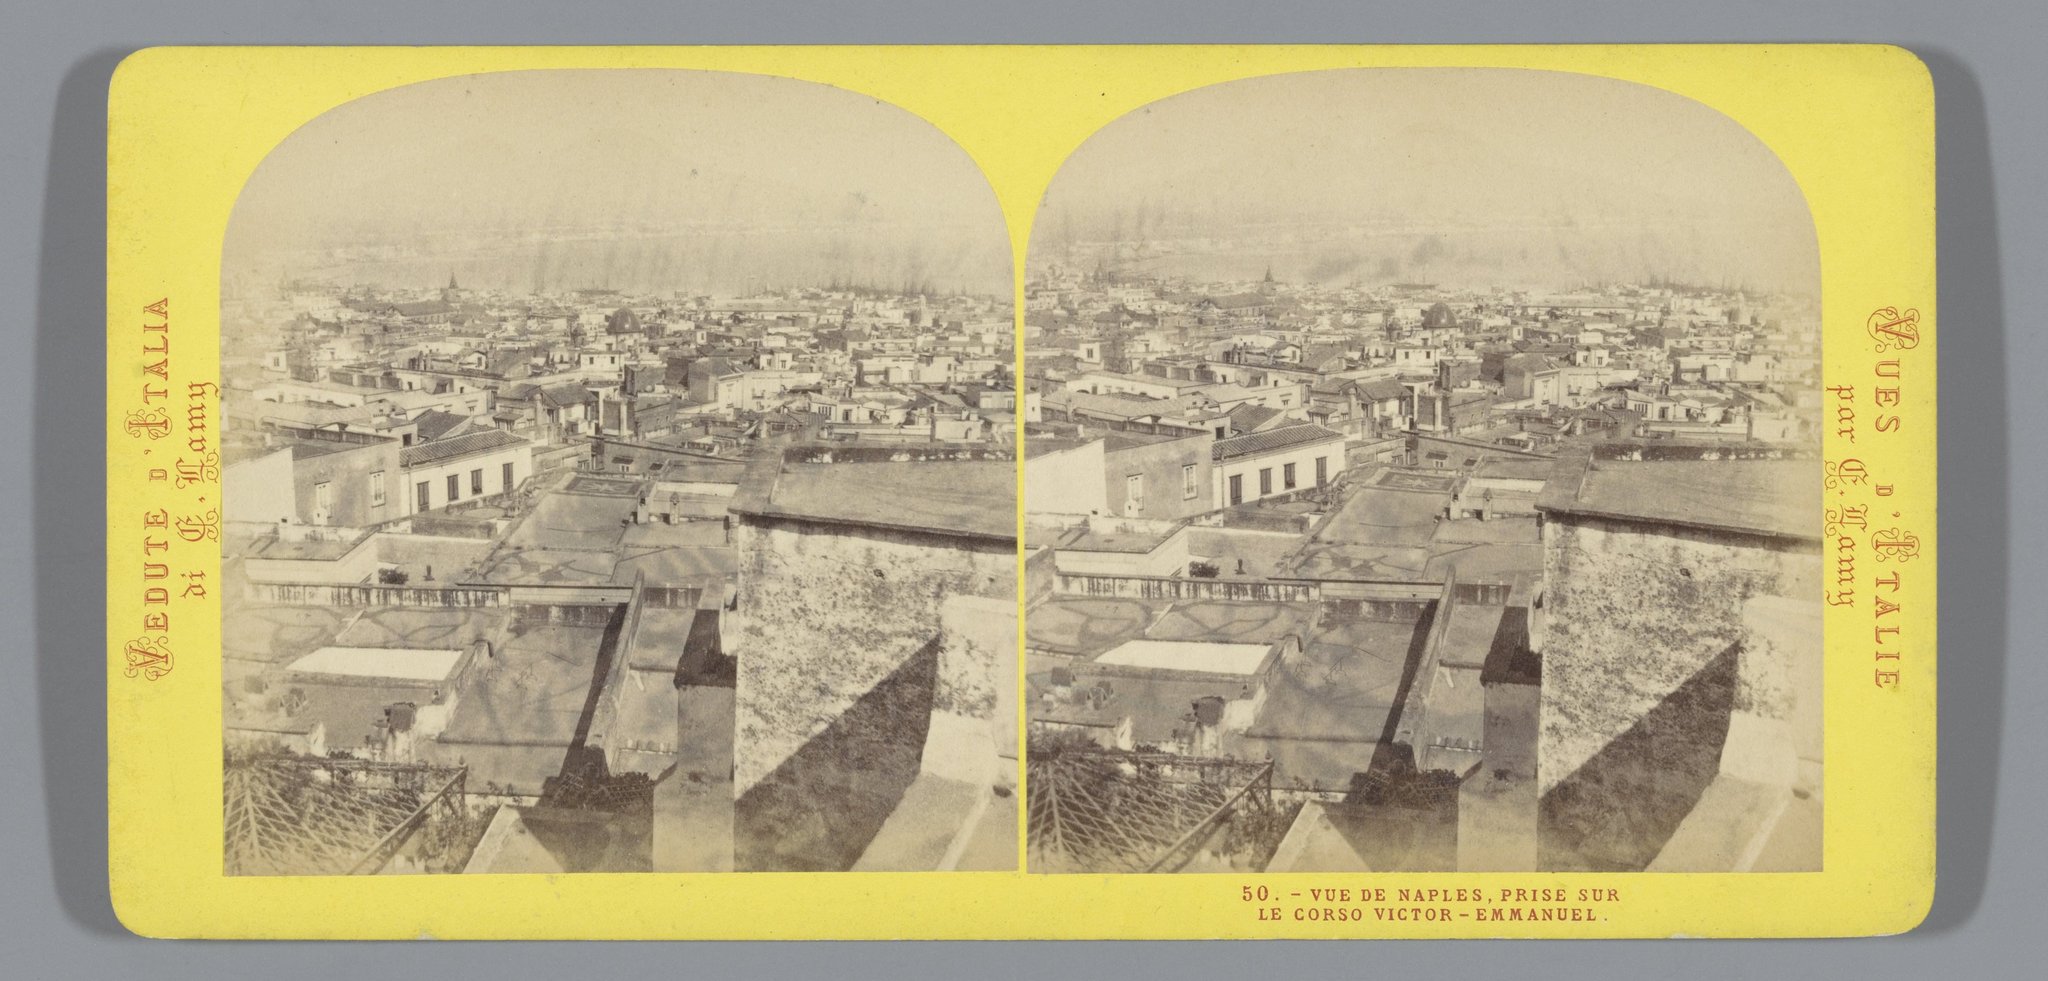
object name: stereograph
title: Gezicht op Napels met daarachter de baai en de Vesuvius, gezien vanaf de Corso Vittorio Emanuele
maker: ernest eléonor pierre lamy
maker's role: publisher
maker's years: 1828-1900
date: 1861-1878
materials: cardboard, paper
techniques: albumen print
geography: naples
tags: gulf, bay, city-view in general; 'veduta', naples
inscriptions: number: ‘50.’